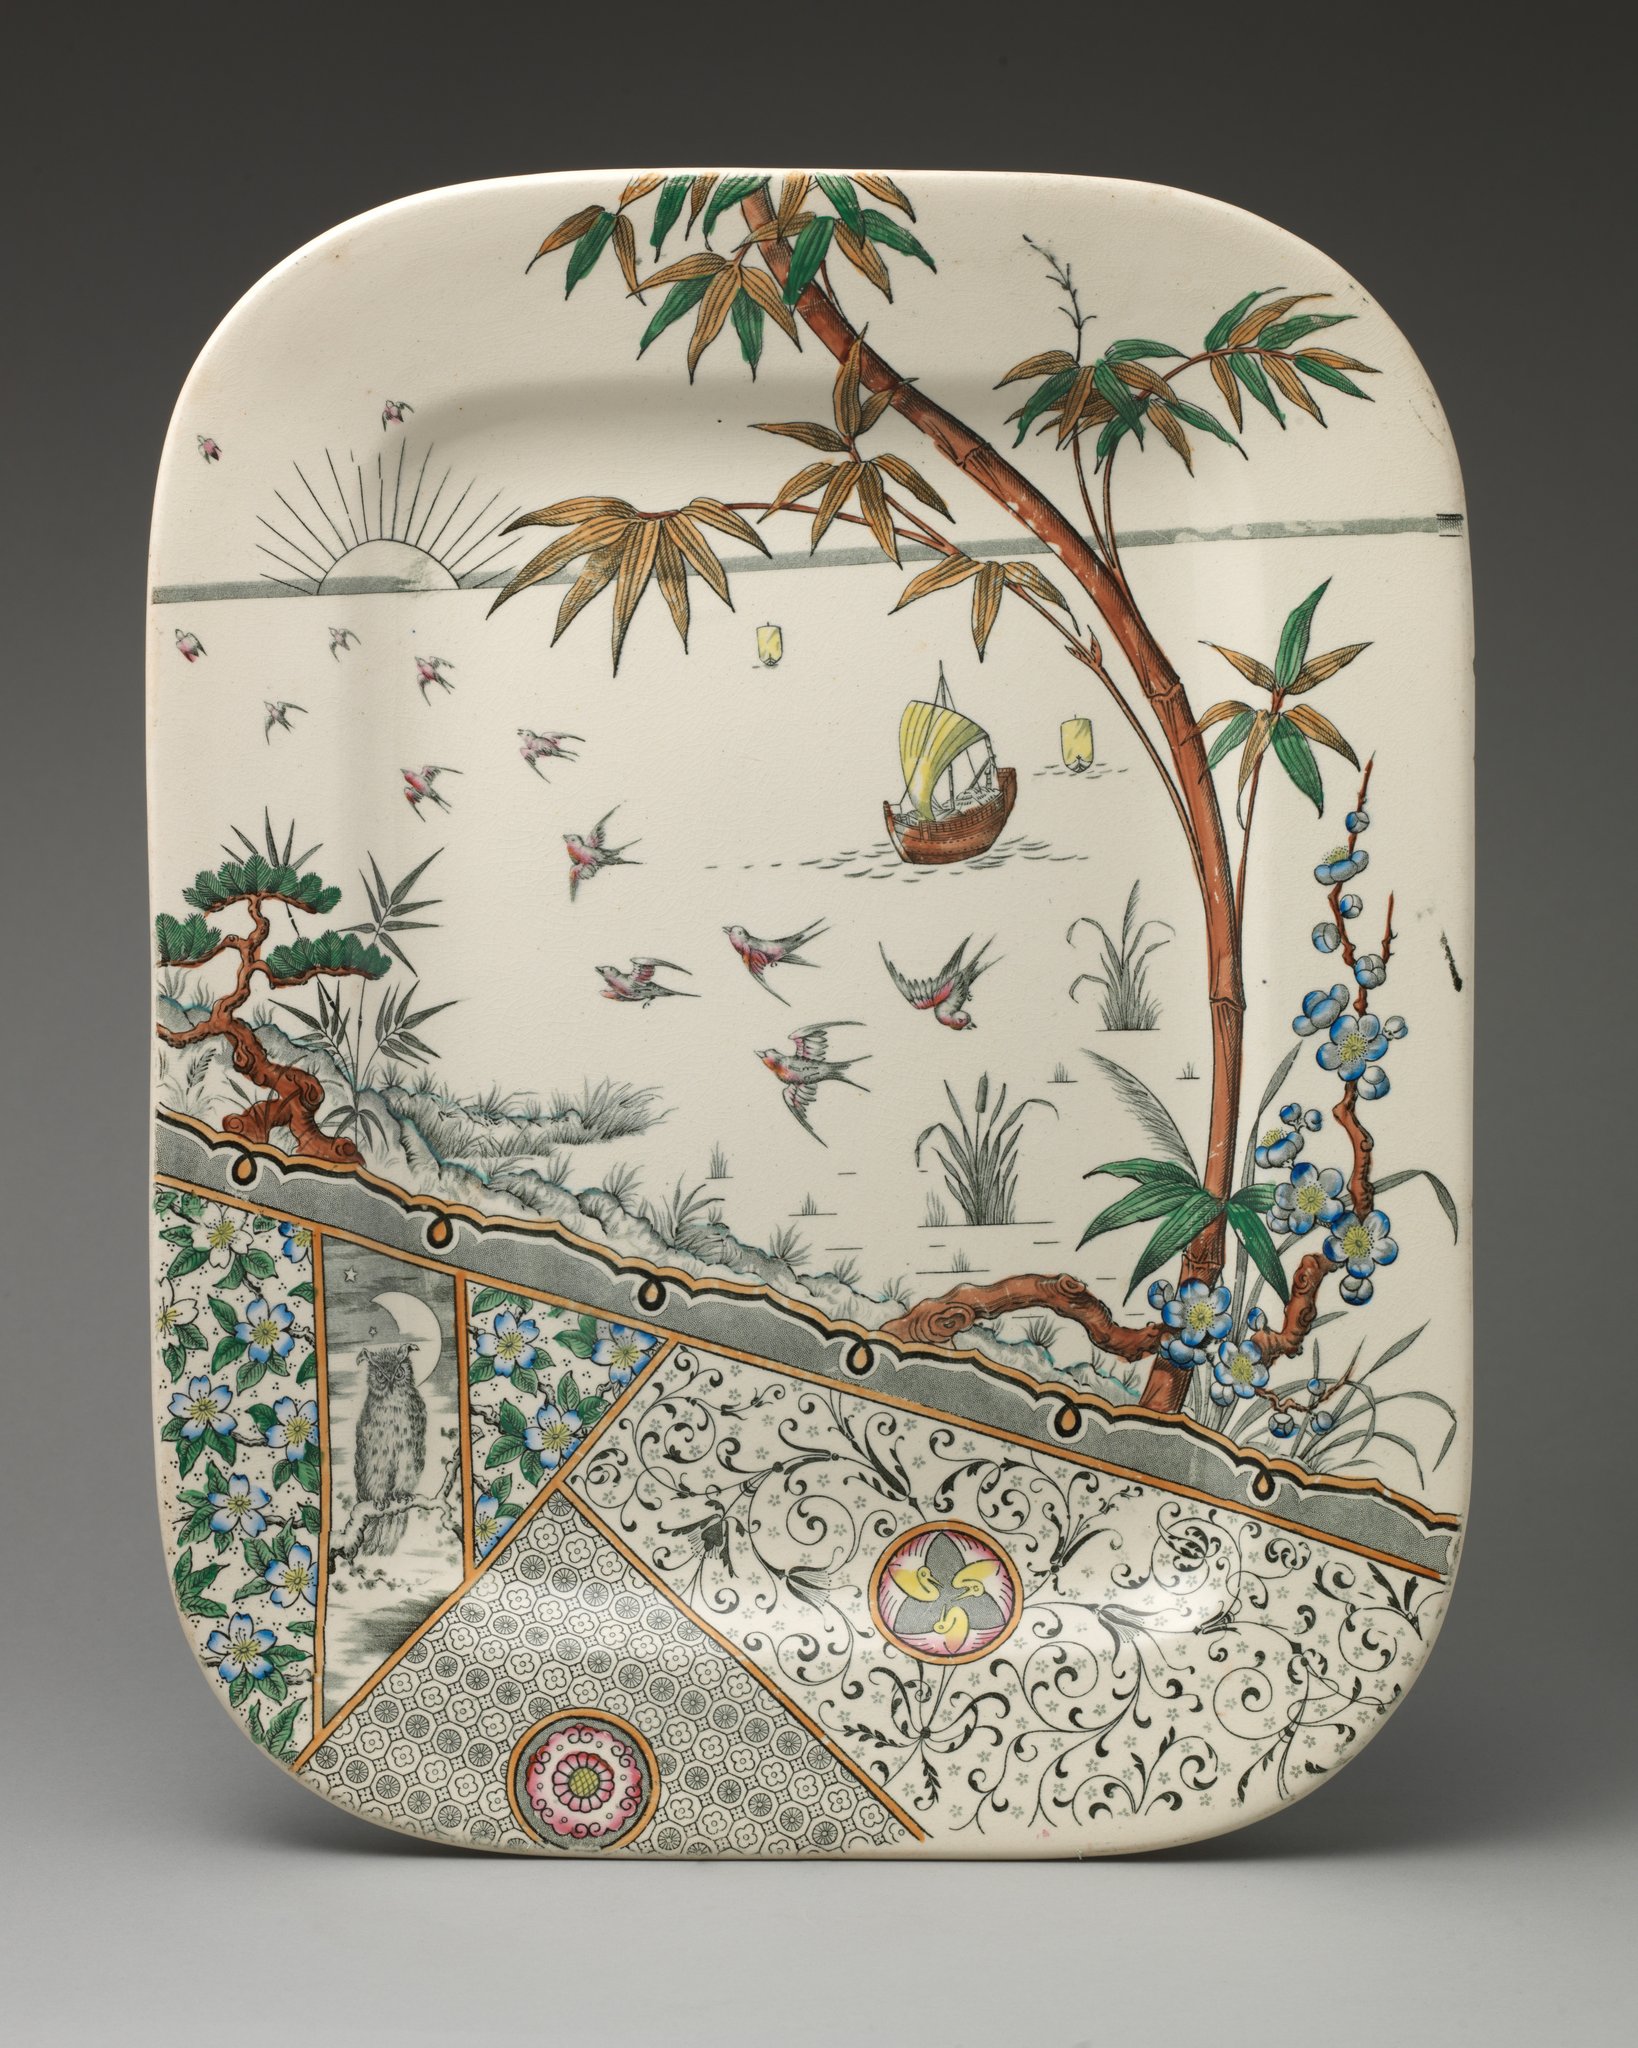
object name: platter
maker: gildea and walker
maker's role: factory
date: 1881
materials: earthenware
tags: birds,trees,boats